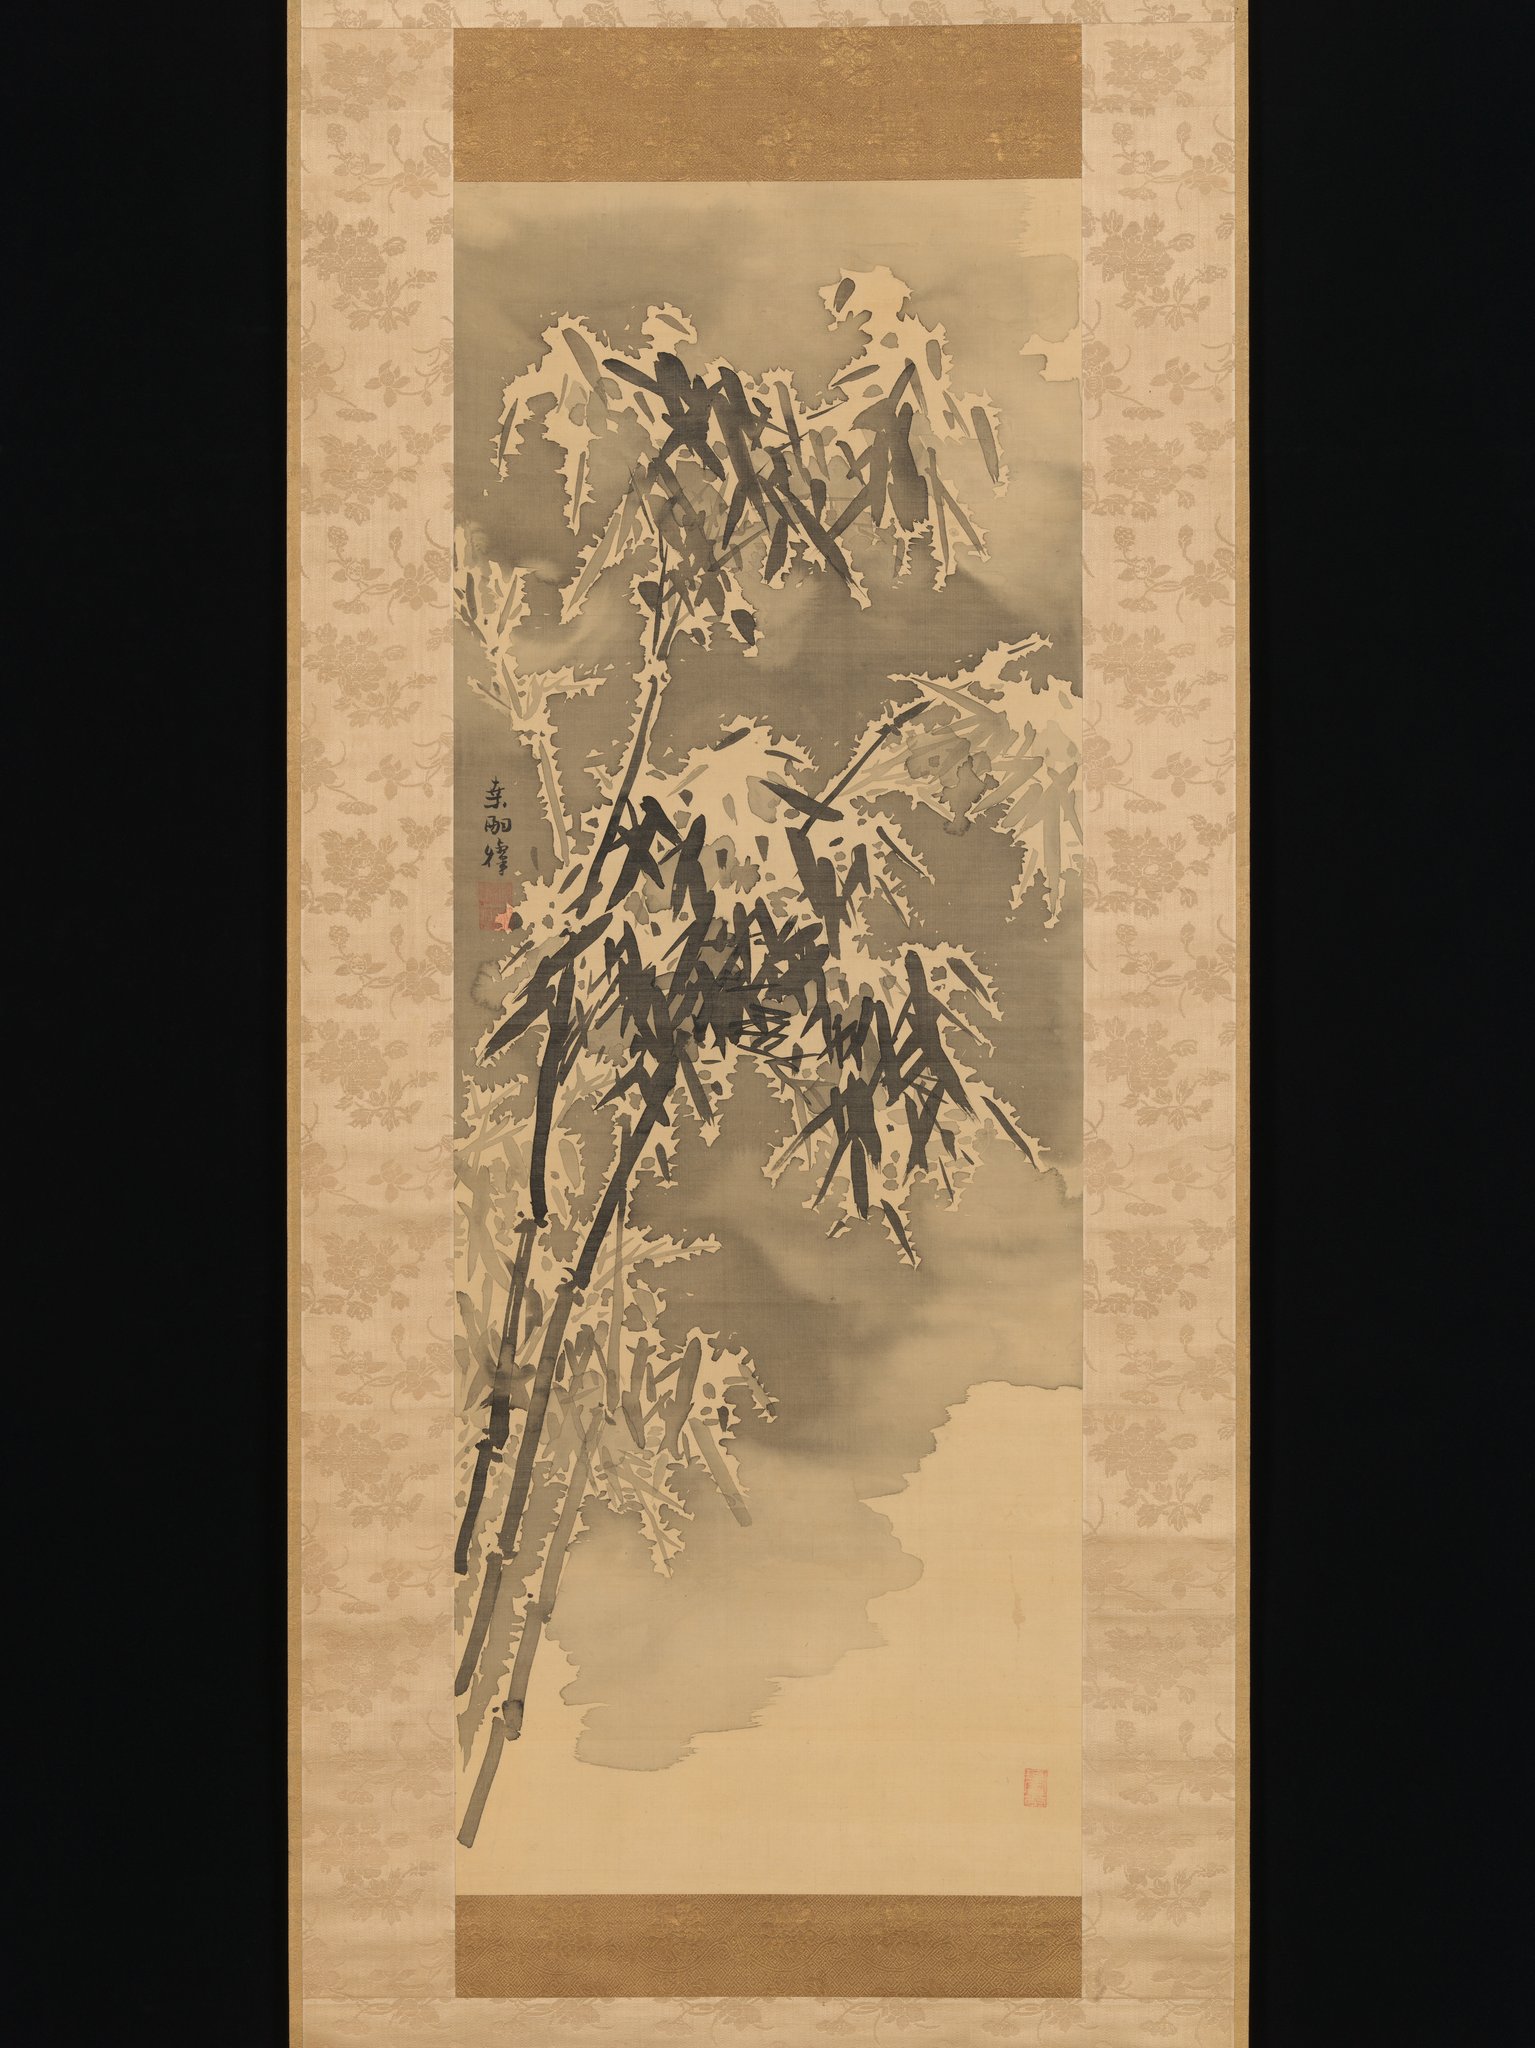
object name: hanging scroll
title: Bamboo and Rock in Snow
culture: japanese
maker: kuwayama gyokushū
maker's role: artist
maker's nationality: japanese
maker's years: 1746-1799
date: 1767-1800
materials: ink, silk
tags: bamboo,snow